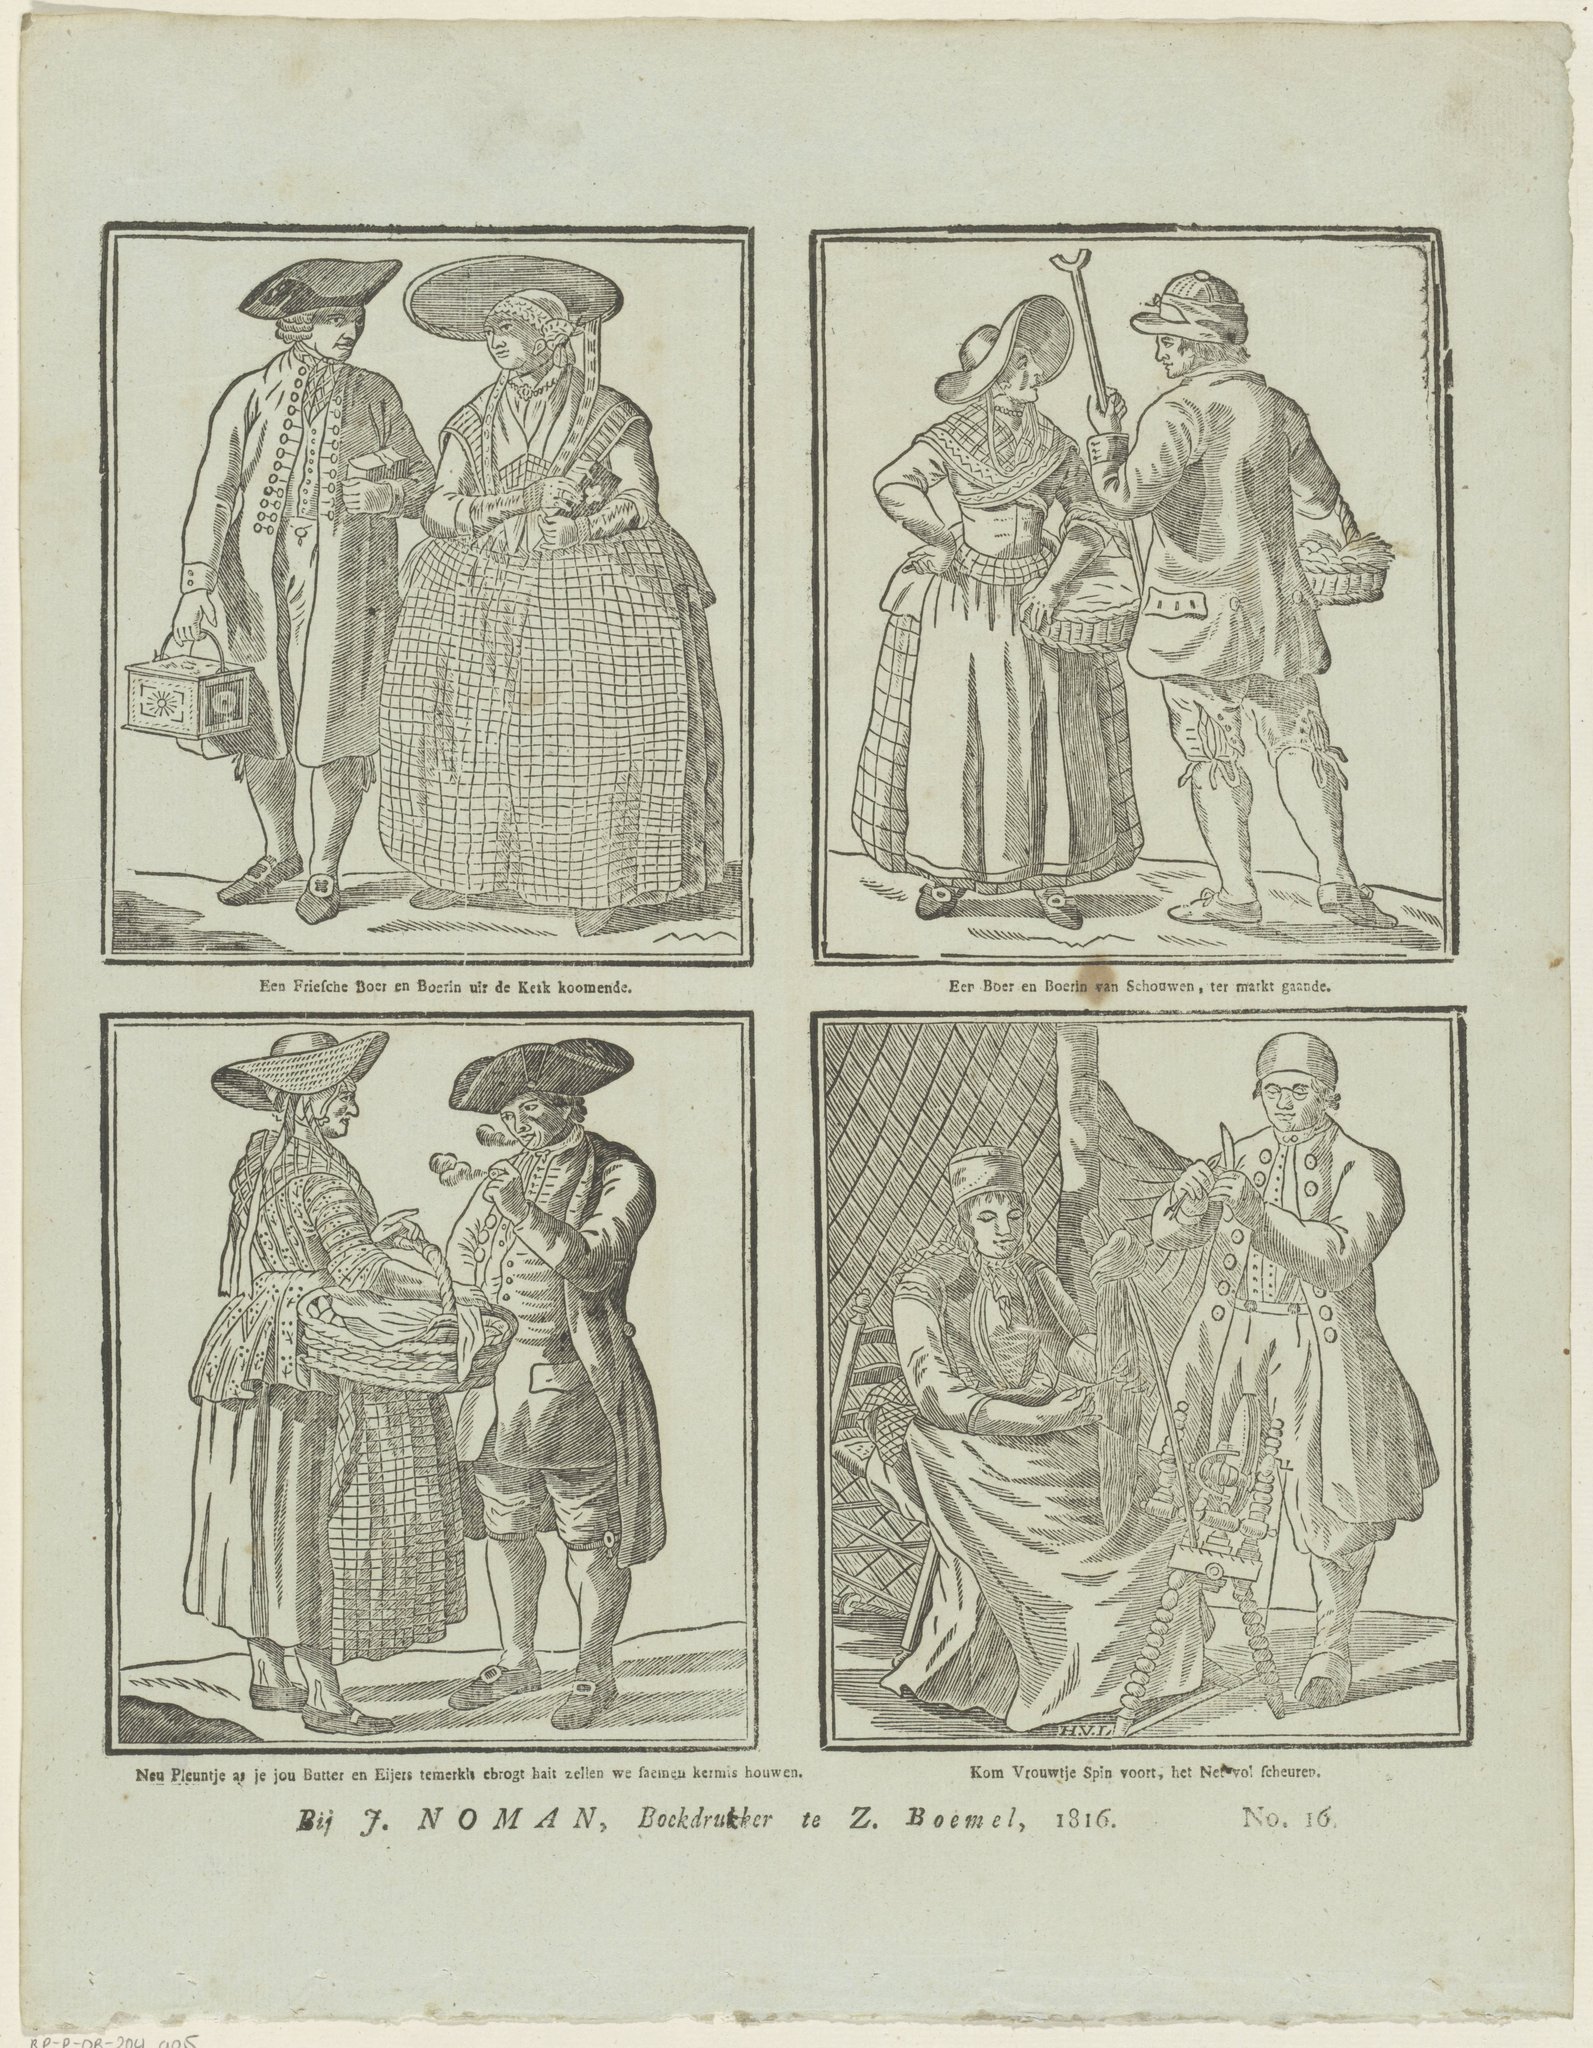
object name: print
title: Regionale klederdrachten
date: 1806-1830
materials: paper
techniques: letterpress printing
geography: netherlands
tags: historical costume, folk costume, regional costume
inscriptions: collector's mark: Lugt 2760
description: Blad met 4 voorstellingen van paren in verschillende Nederlandse klederdrachten. Onder elke afbeelding een onderschrift. Genummerd rechtsonder: No. 16.